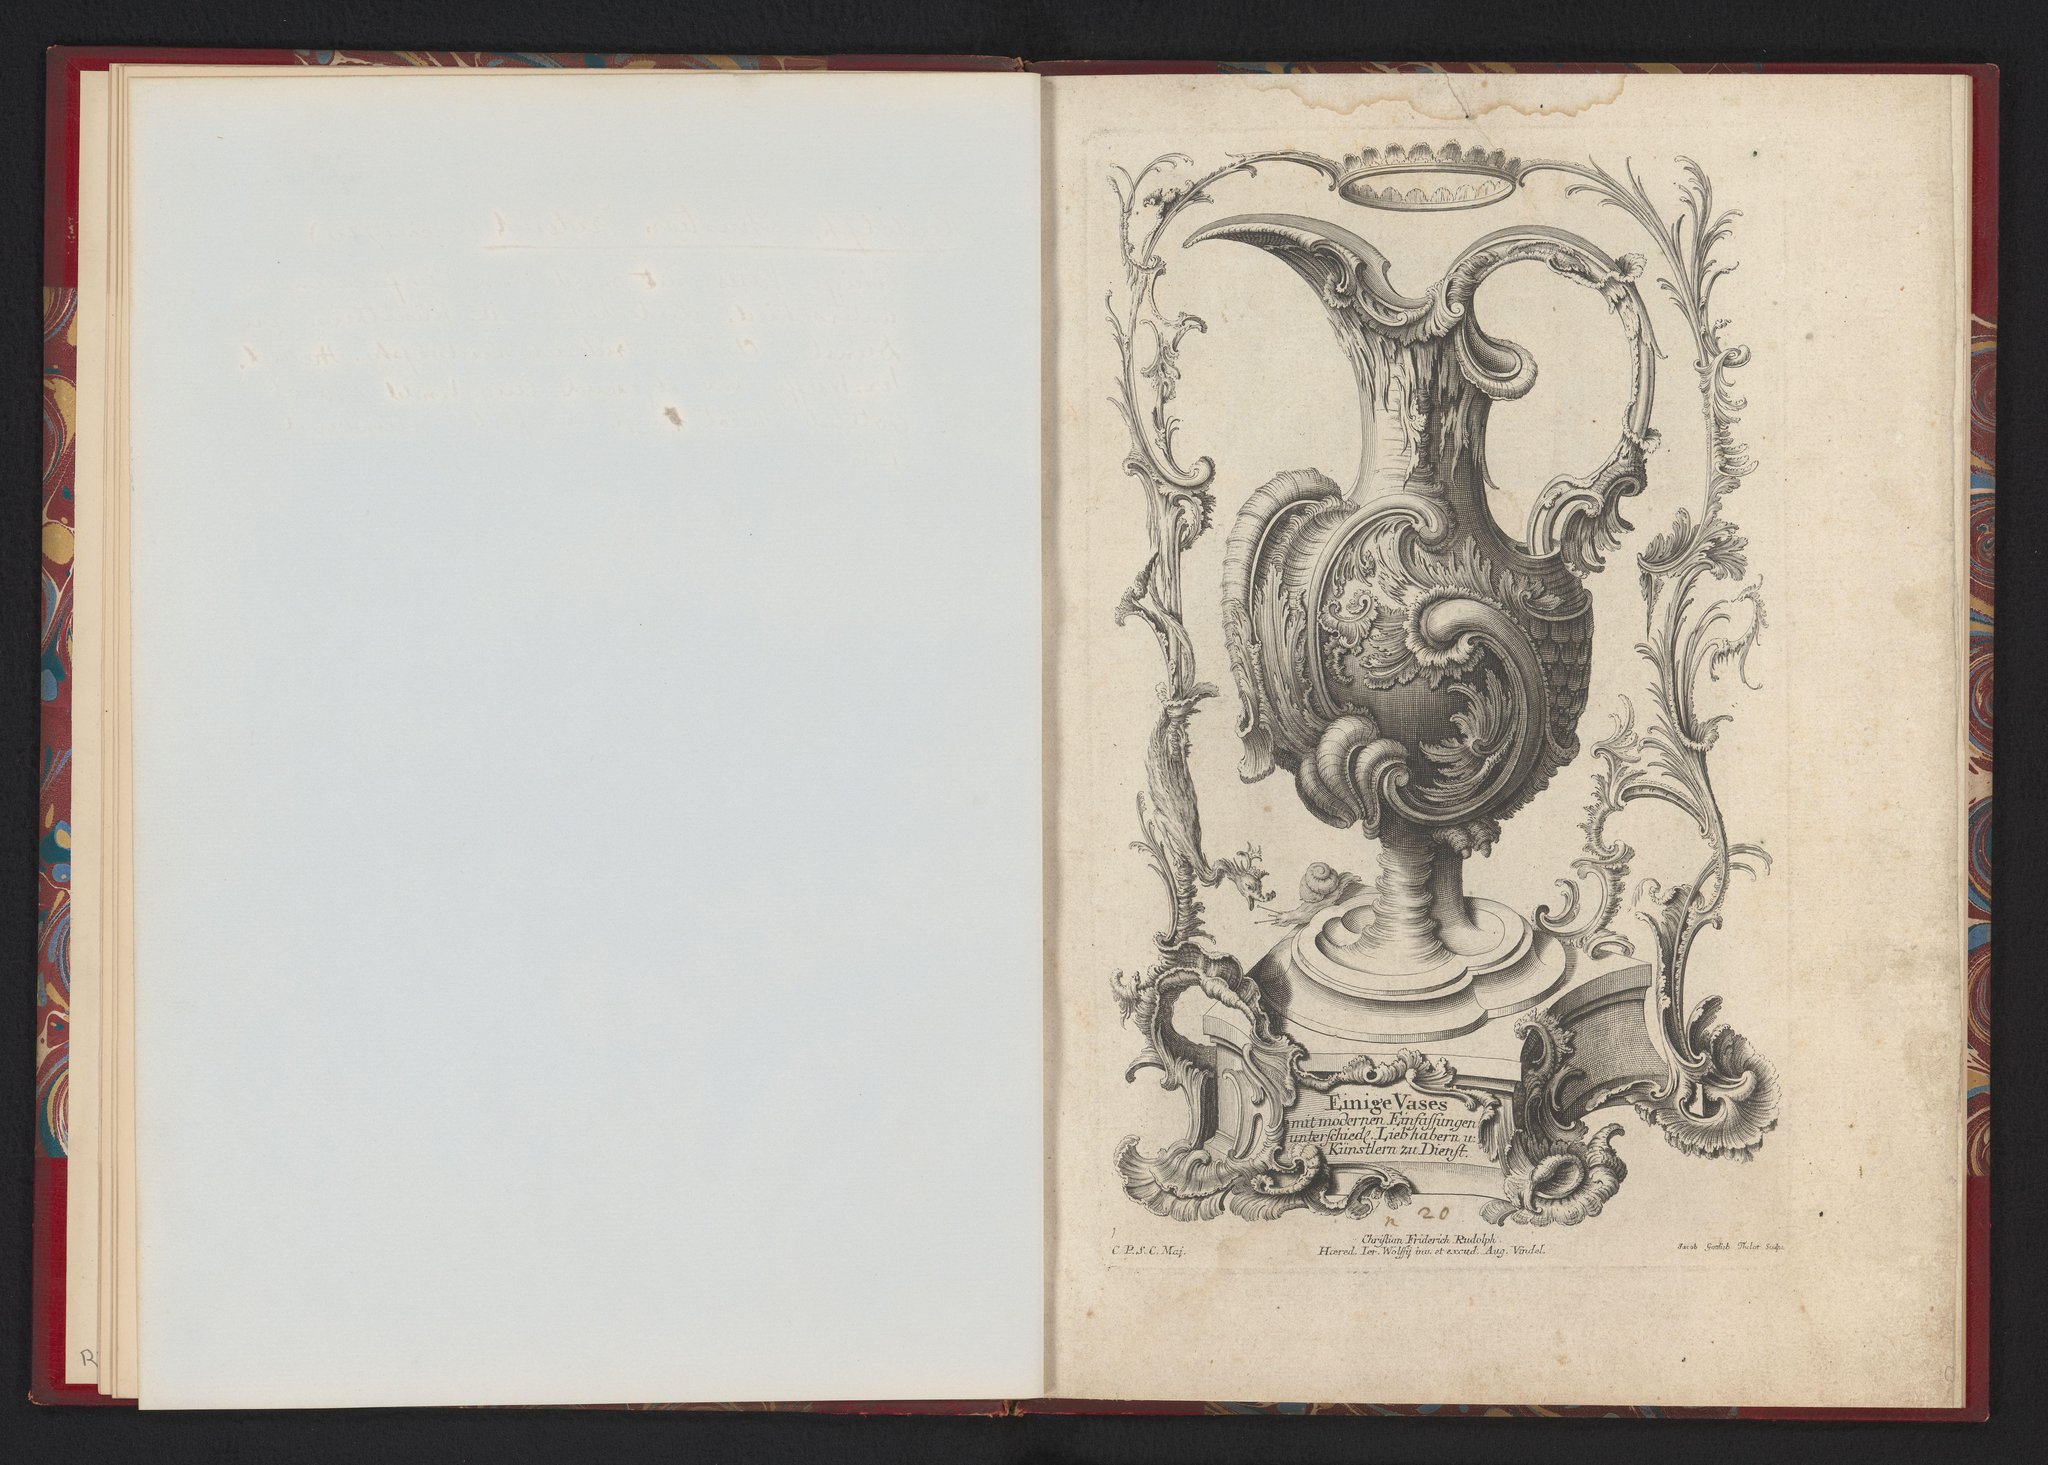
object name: titelprent, frontispice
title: Siervazen en -kannen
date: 1750-1770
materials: paper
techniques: etching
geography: augsburg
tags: crown (symbol of sovereignty), ornaments ~ art, rocaille ornament, vase ~ ornament, title-page, jar, jug (used as drinking-vessel), molluscs: snail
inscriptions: signature: ‘Jacob Gottlieb Thelot Sculps.’, signature: ‘C.P.S.C. Maj.’, signature: ‘Christian Friderich Rudolph / Hoered. Ier. Wolffij inv. et excud. Aug. Vindel’, number: ‘1’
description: Ontwerp voor een vaas met een kroon en aan de voet een slak. In de voet de titel van de serie. Prent maakt deel uit van een album.